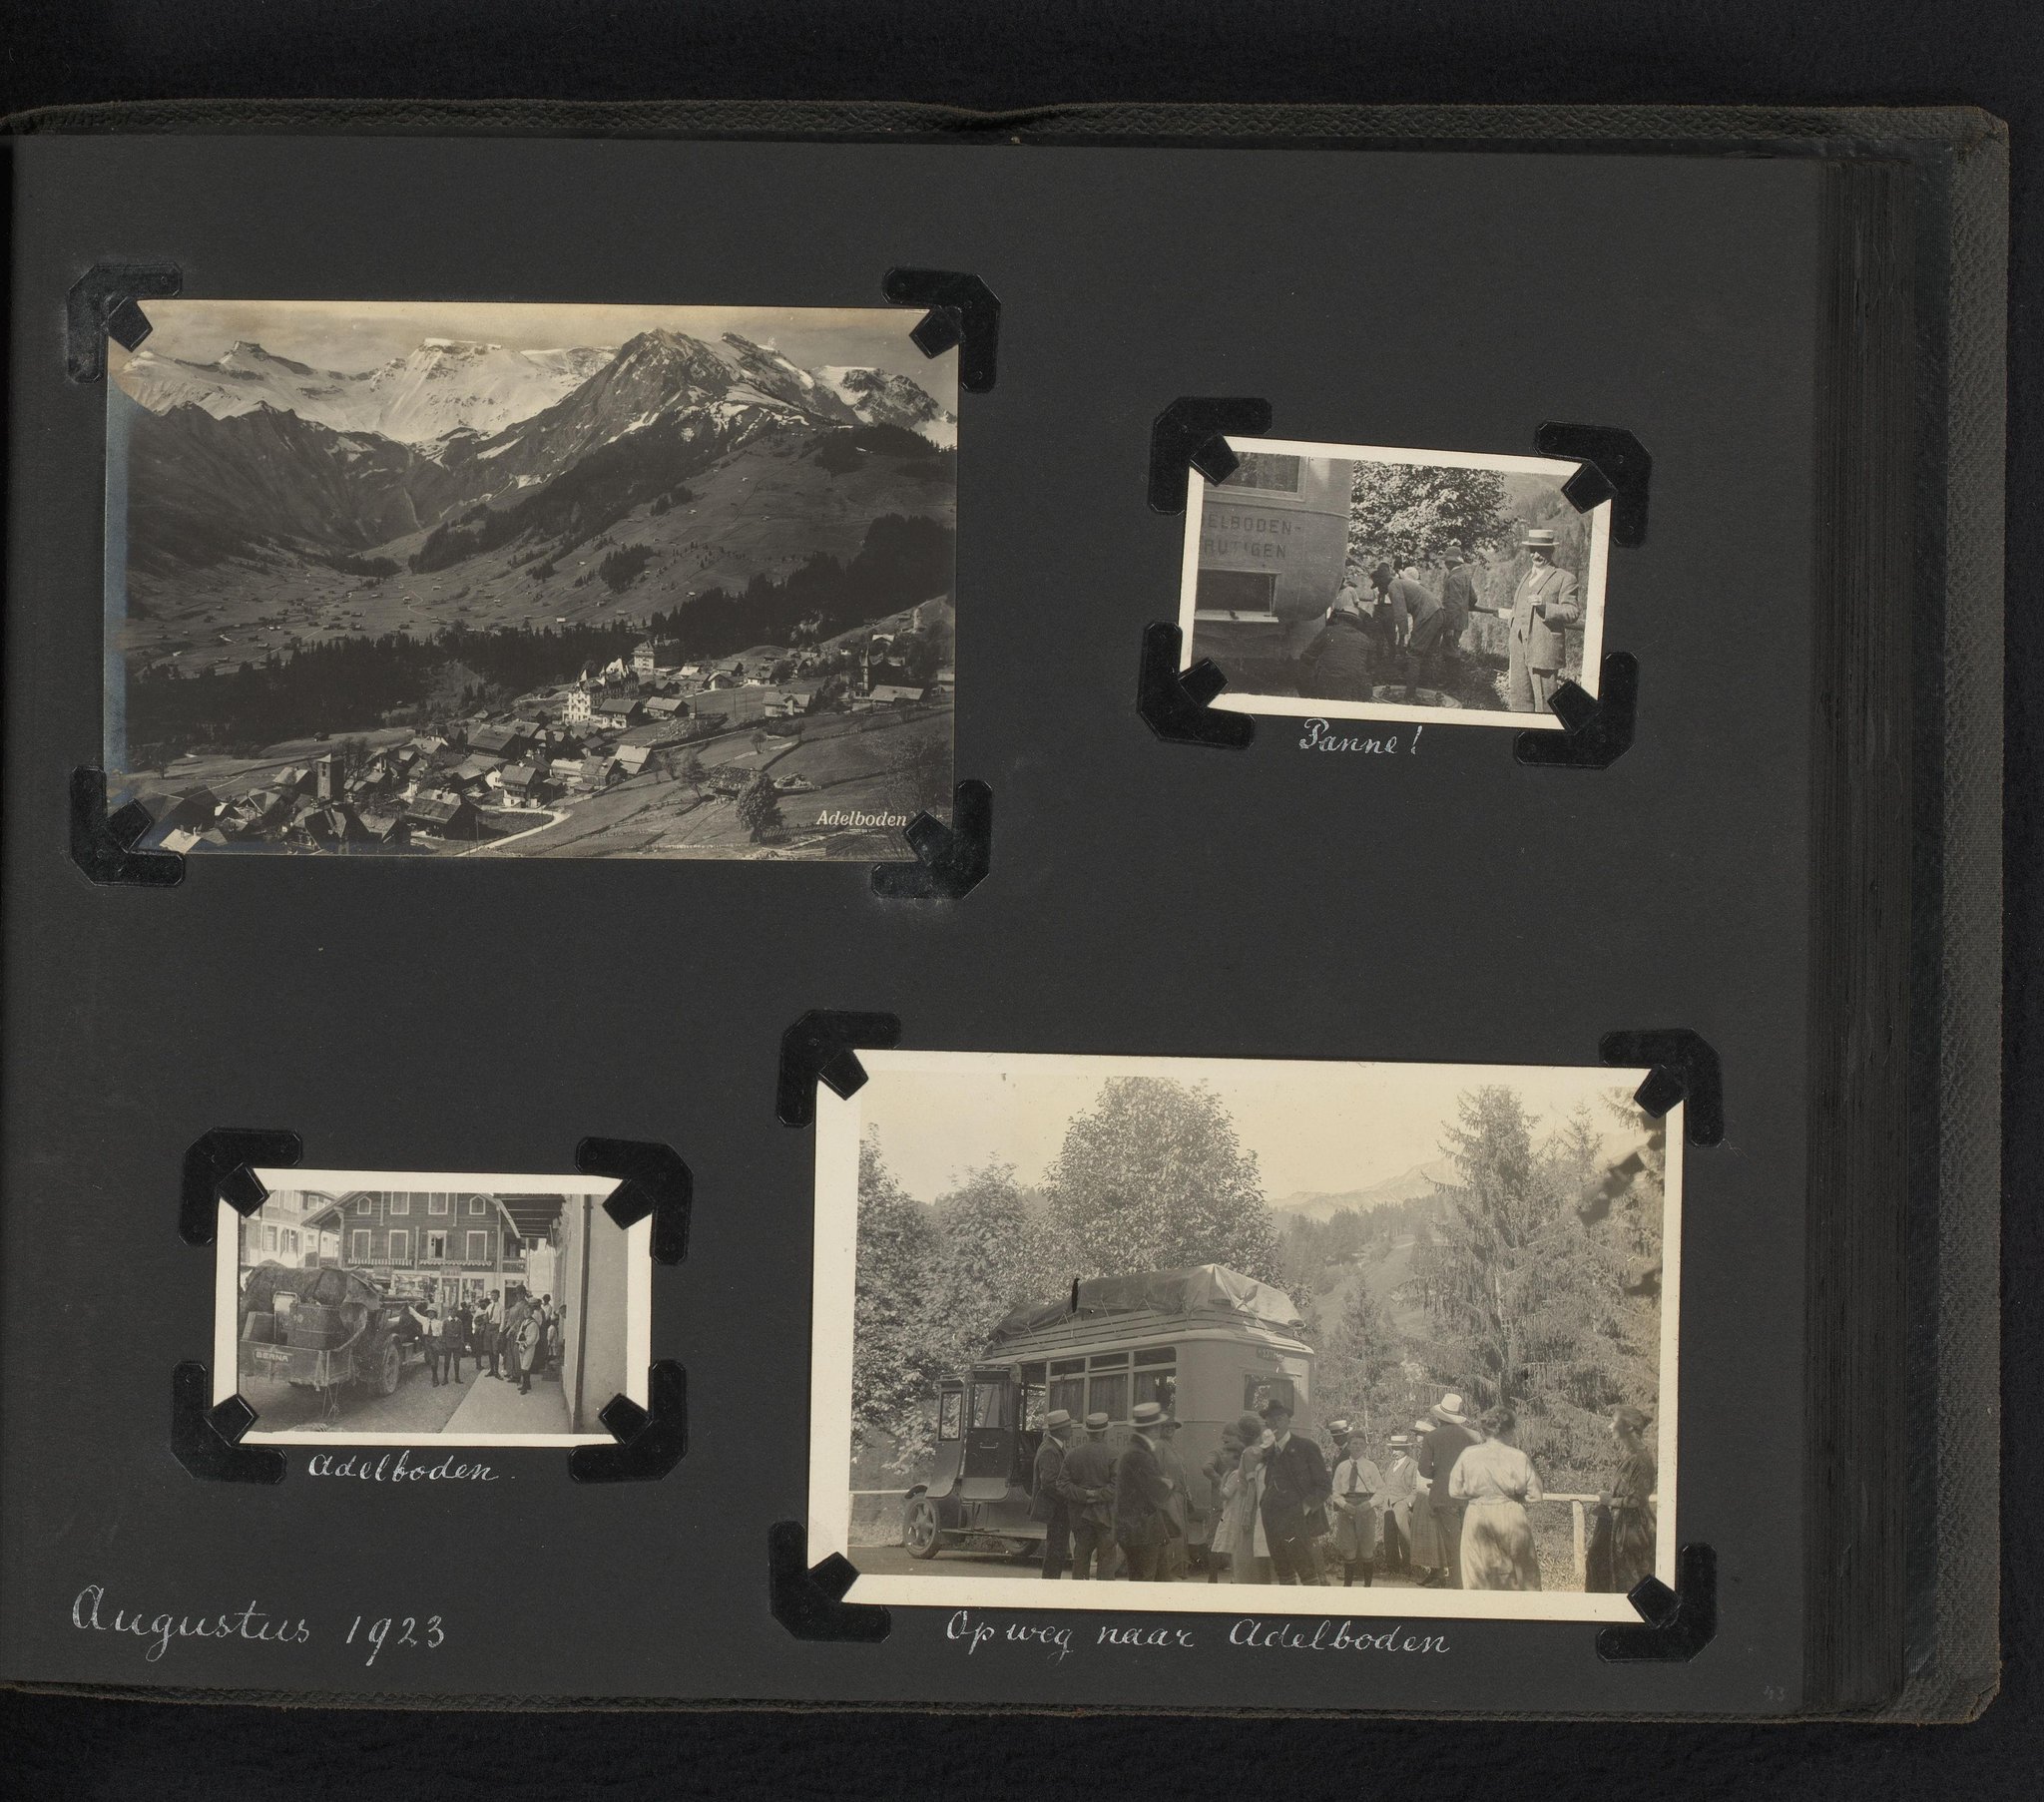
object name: photograph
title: Augustus 1923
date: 1908-1923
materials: paper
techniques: gelatin silver print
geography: bern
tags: bus, coach, village, mountains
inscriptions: inscription: ‘Adelboden’, inscription: ‘Op weg naar Adelboden’, inscription: ‘Panne!’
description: Deze foto's maken deel uit van een album.